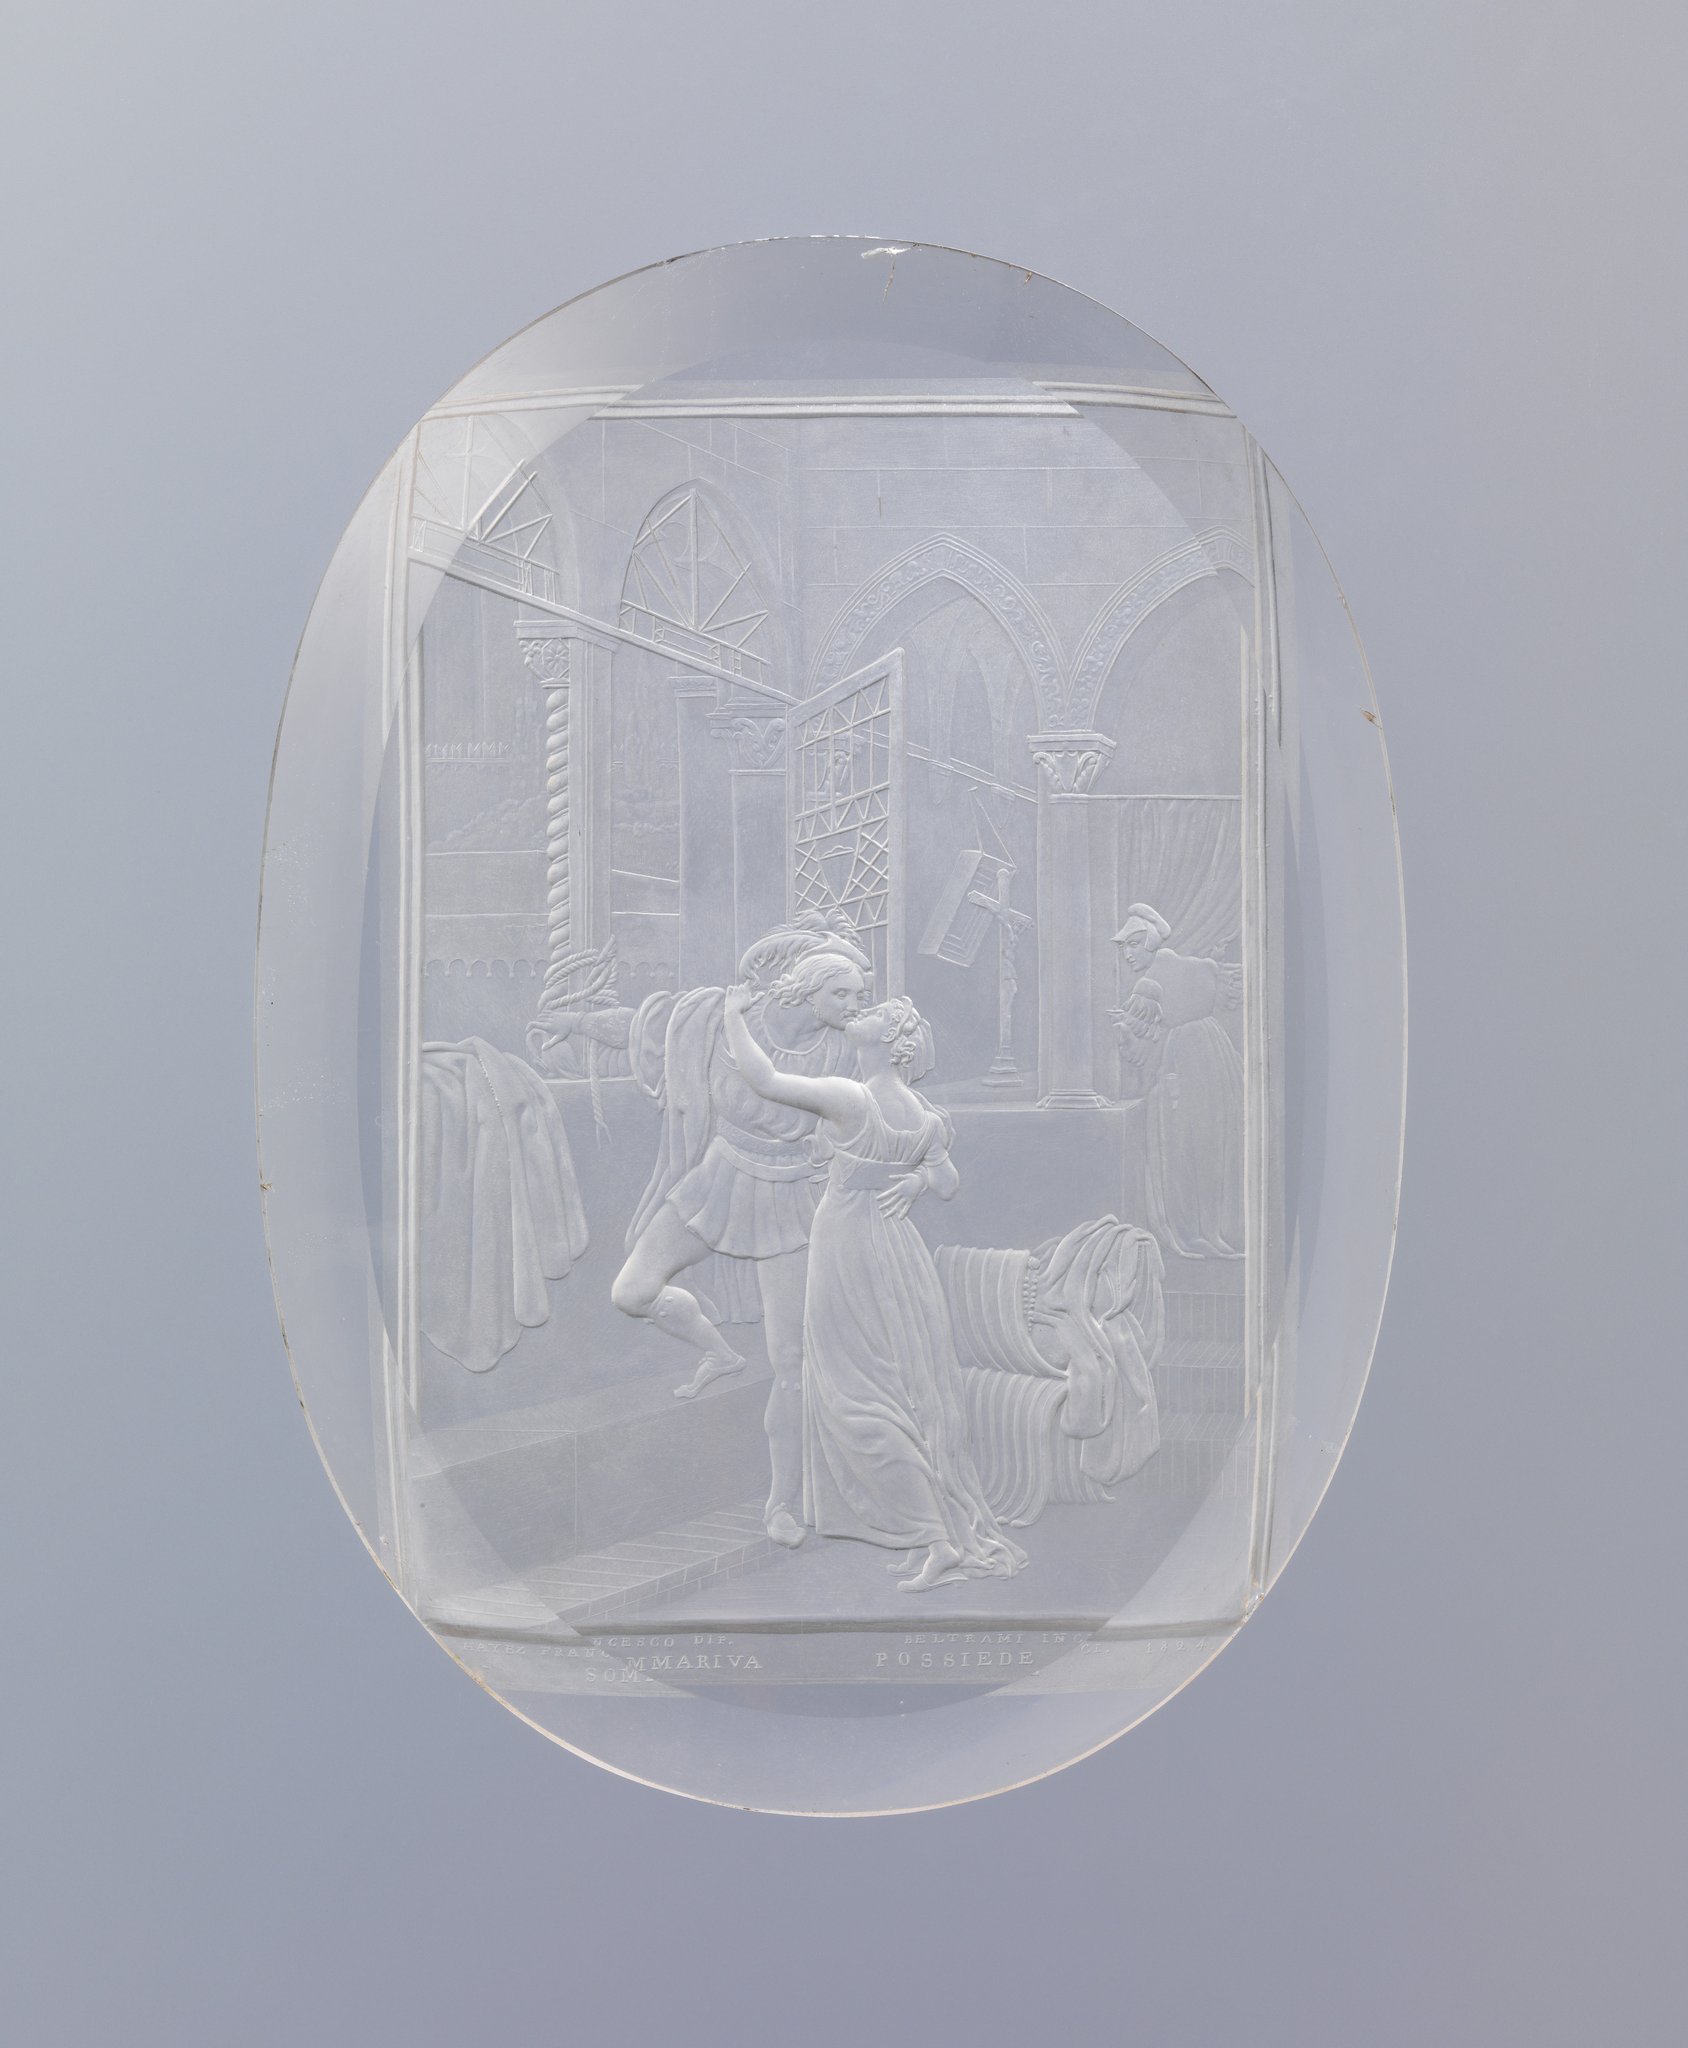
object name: intaglio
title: The Last Kiss of Romeo and Juliet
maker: giovanni beltrami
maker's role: maker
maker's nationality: italian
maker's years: 1770-1854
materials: gilt bronze, quartz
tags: interiors,shakespeare,couples,men,women